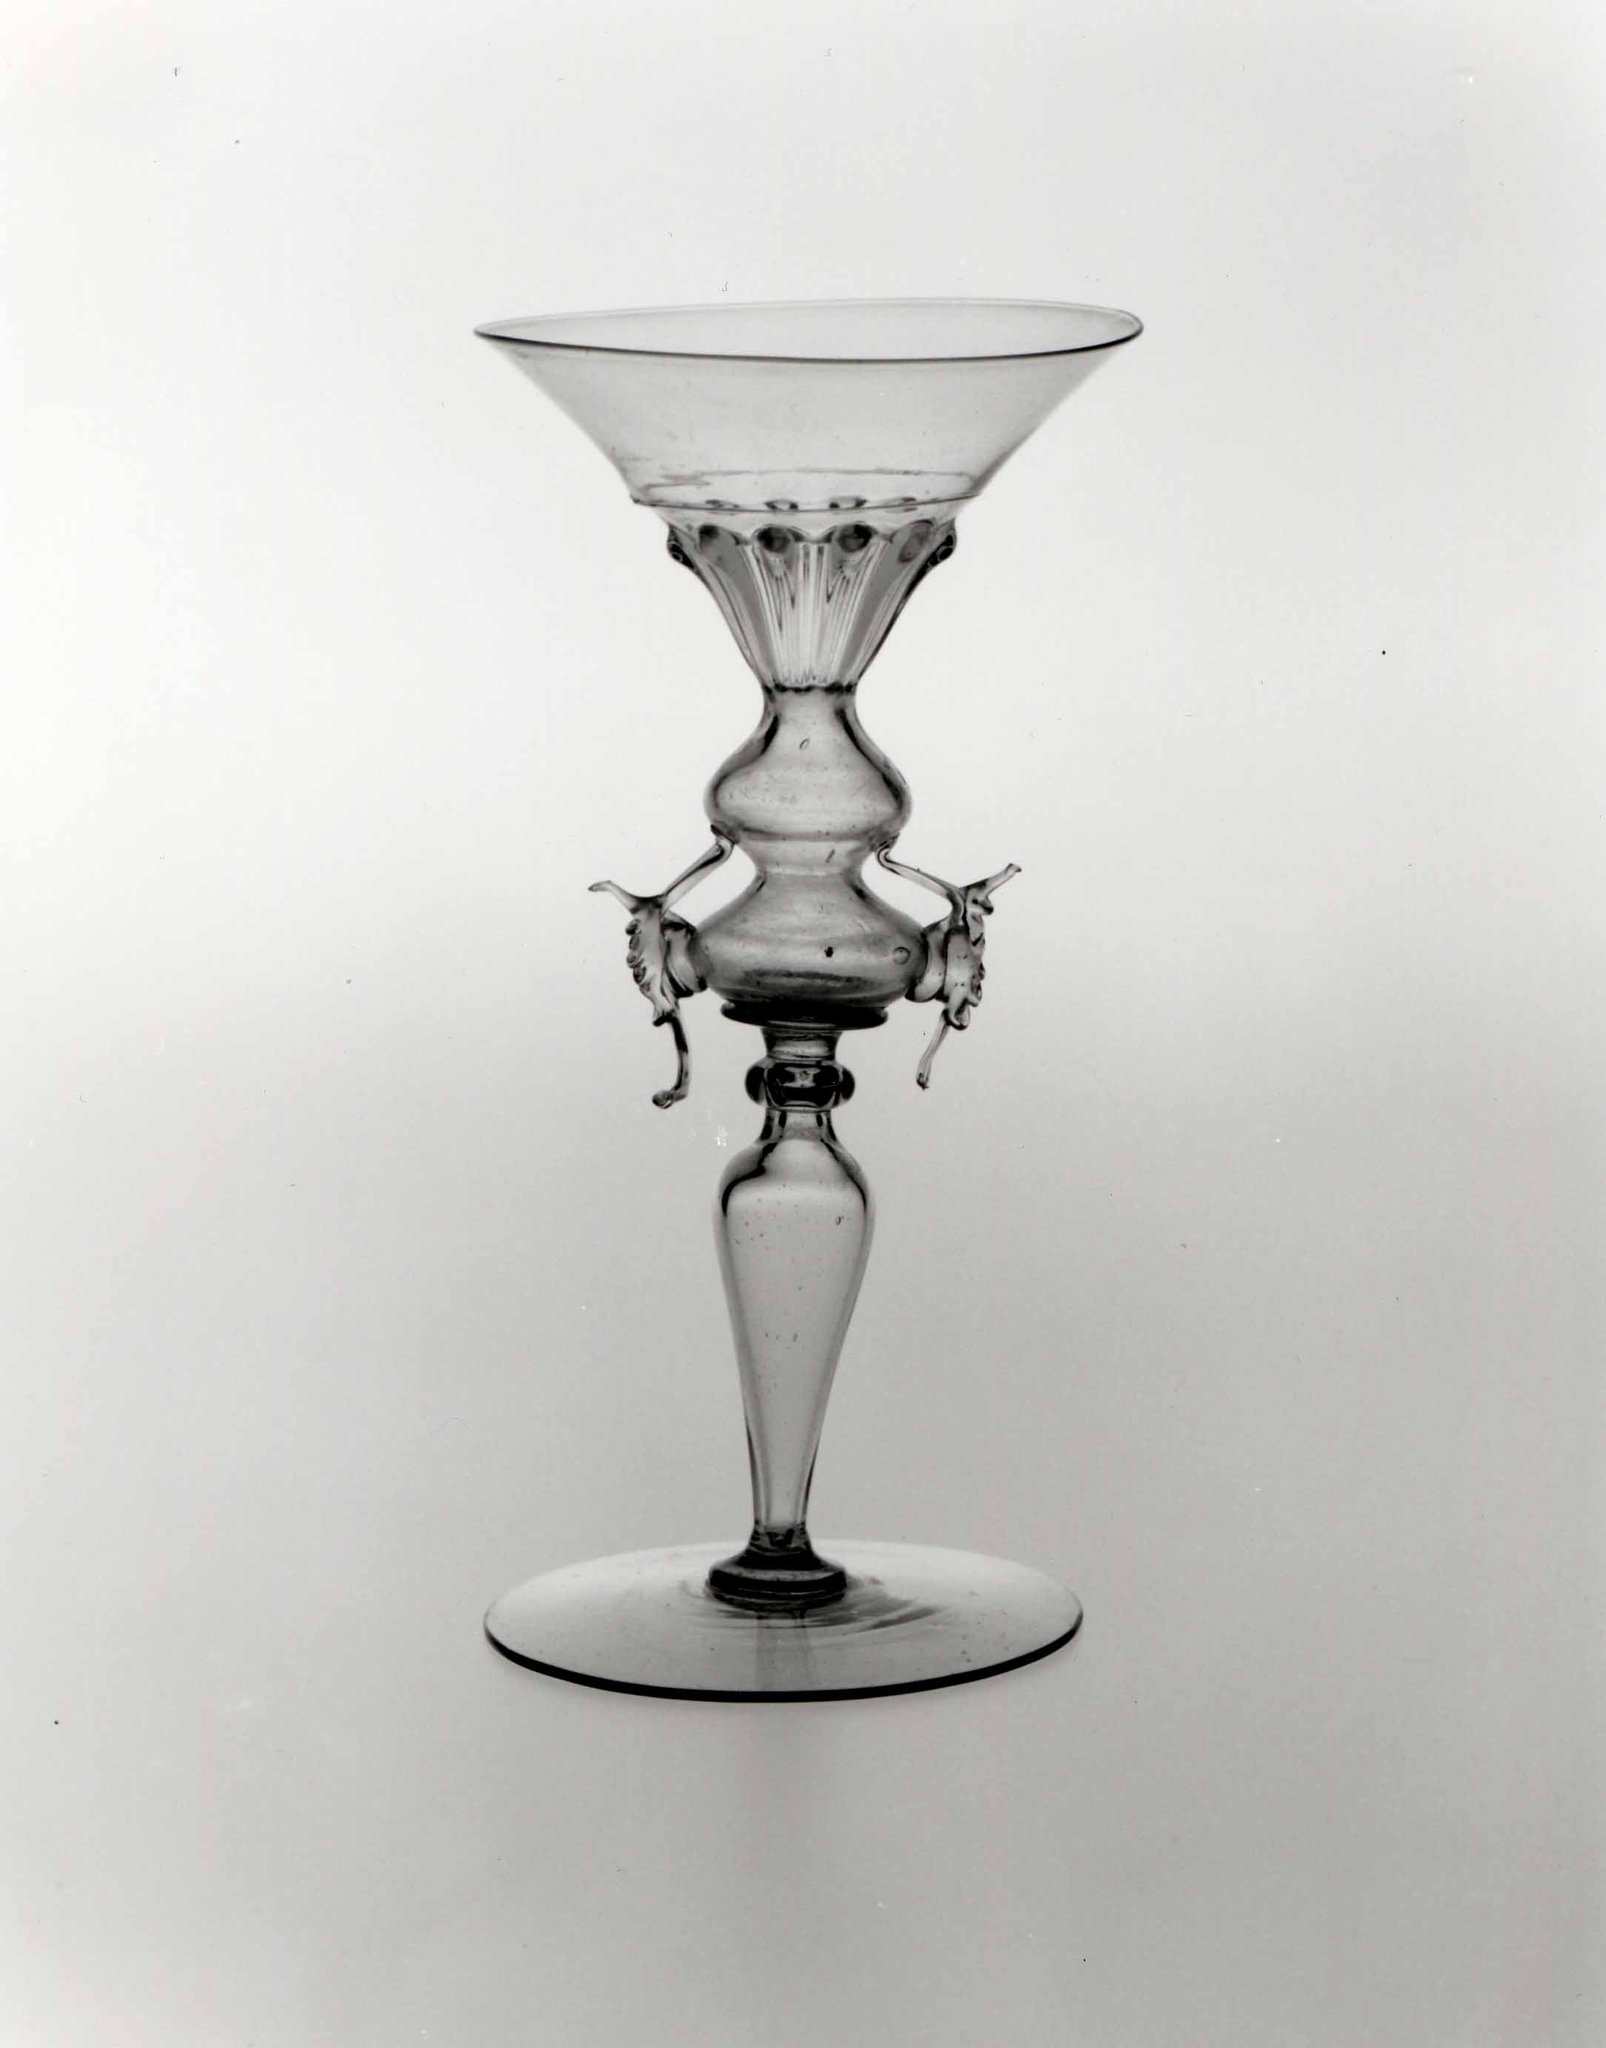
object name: wineglass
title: Wineglass (pastiche)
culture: italian or northern european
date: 1601-1700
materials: glass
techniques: glassblowing, molding